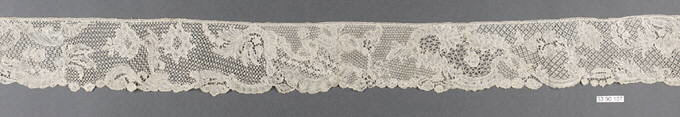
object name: edging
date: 1734-1766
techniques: lace